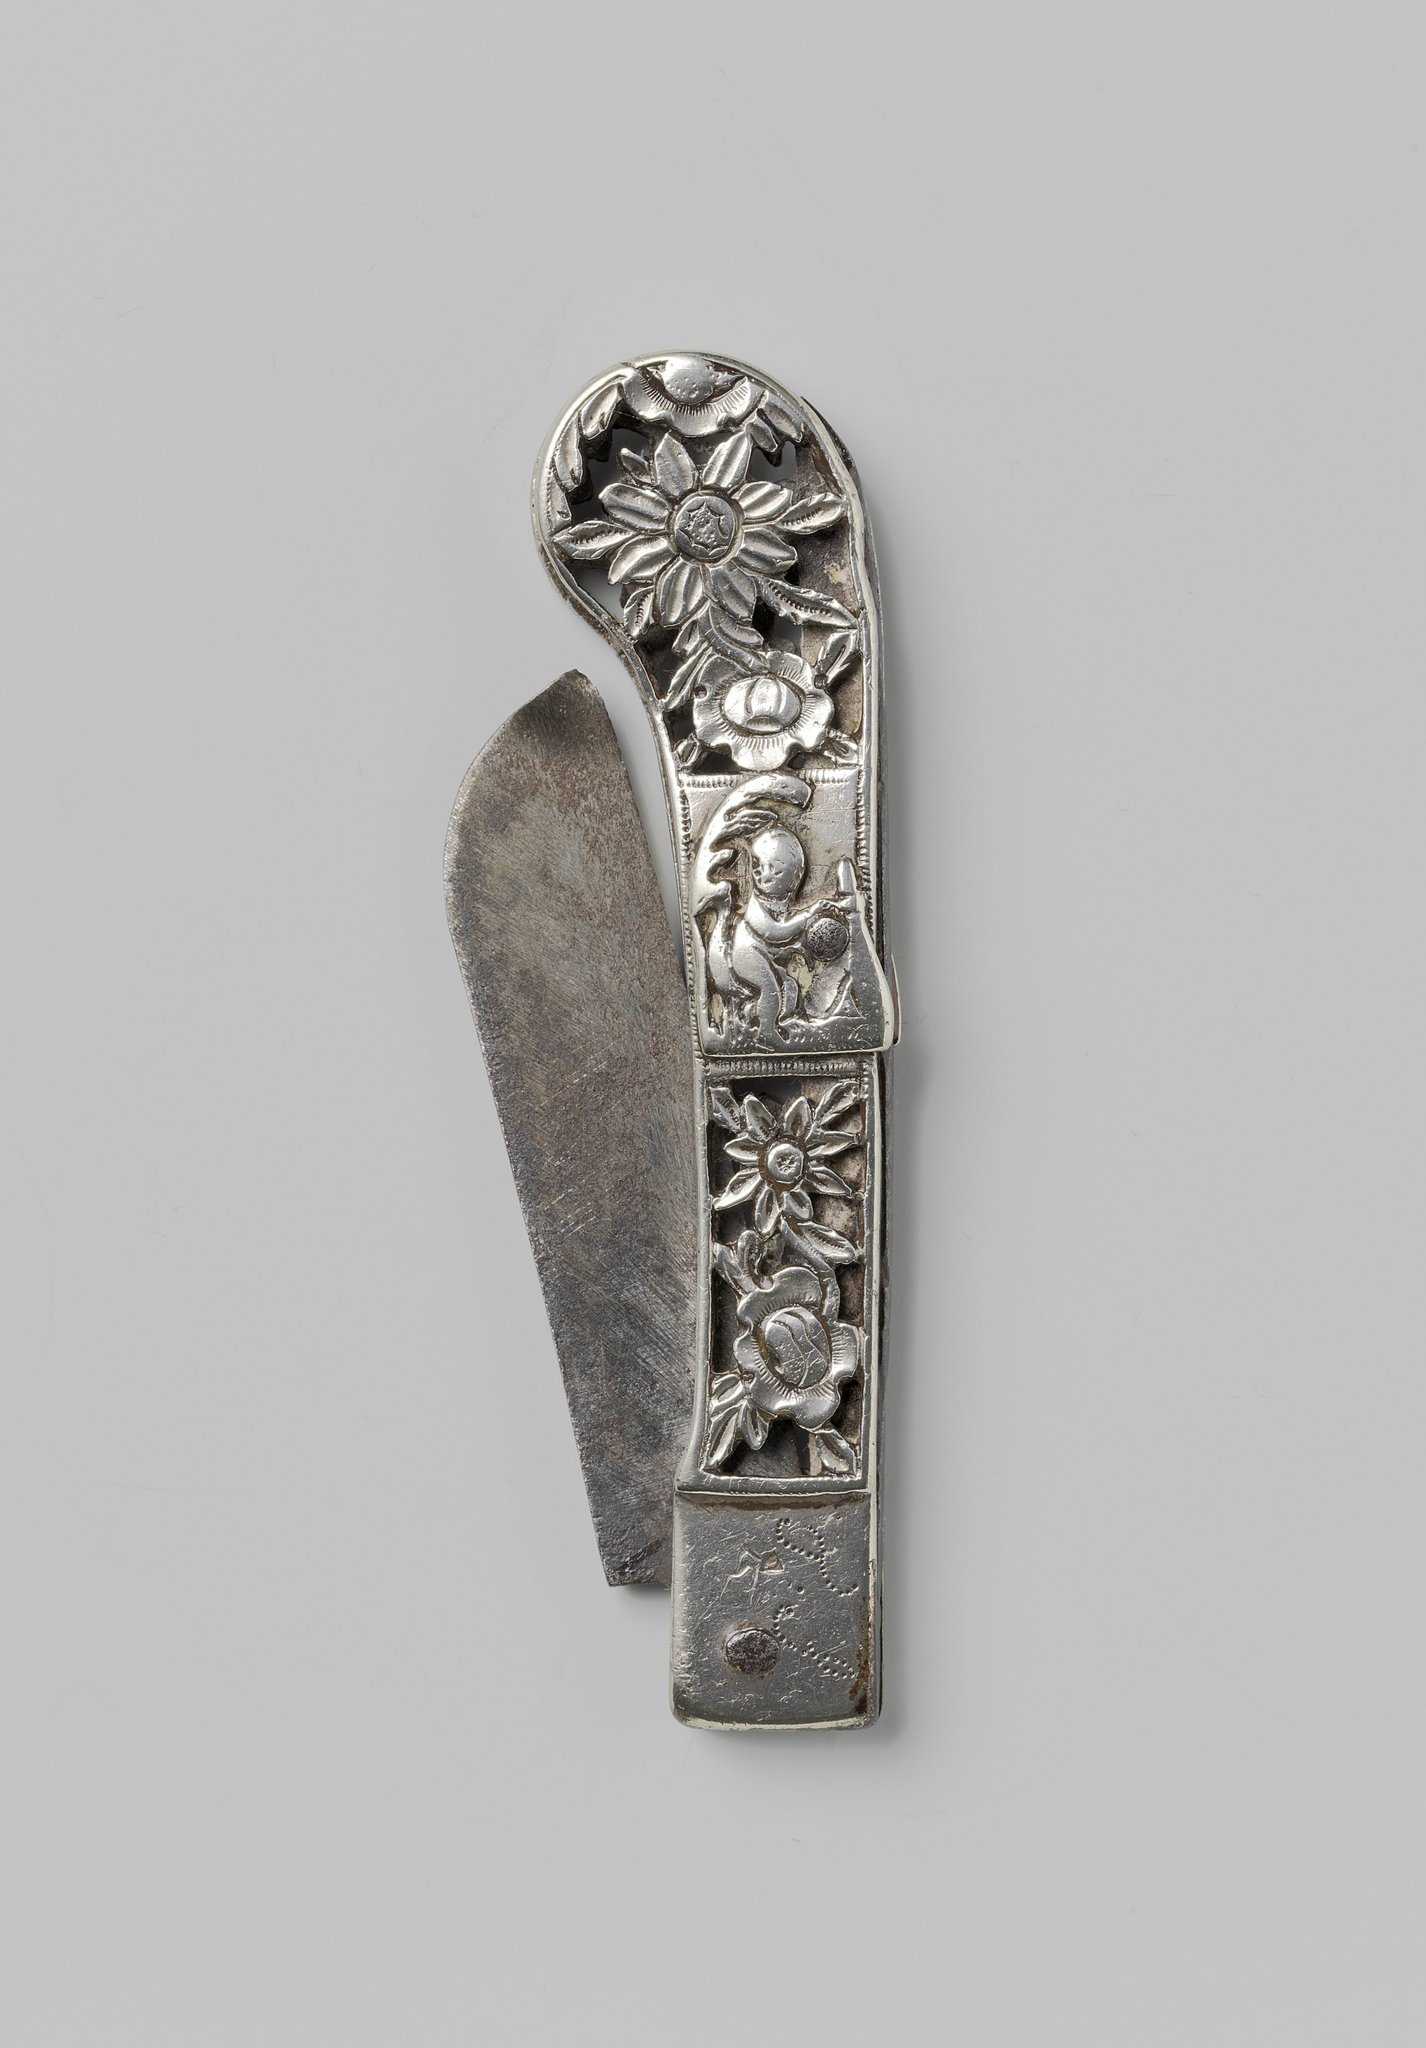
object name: pocket knife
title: Zakmes met zilveren ajour bewerkt heft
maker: albertus antonius rooswinkel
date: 1810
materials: silver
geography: leeuwarden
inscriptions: mark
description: Zakmes met zilveren ajour bewerkt heft met geciseleerde bloemen, waartussen een rechthoekige plaat met een spelend kind in reliëf. Heft en mes gemerkt, Leeuwarden, met een halve leeuw een de jaarletter C = 1810, meesterteken A.R. = Albertus Rooswinkel